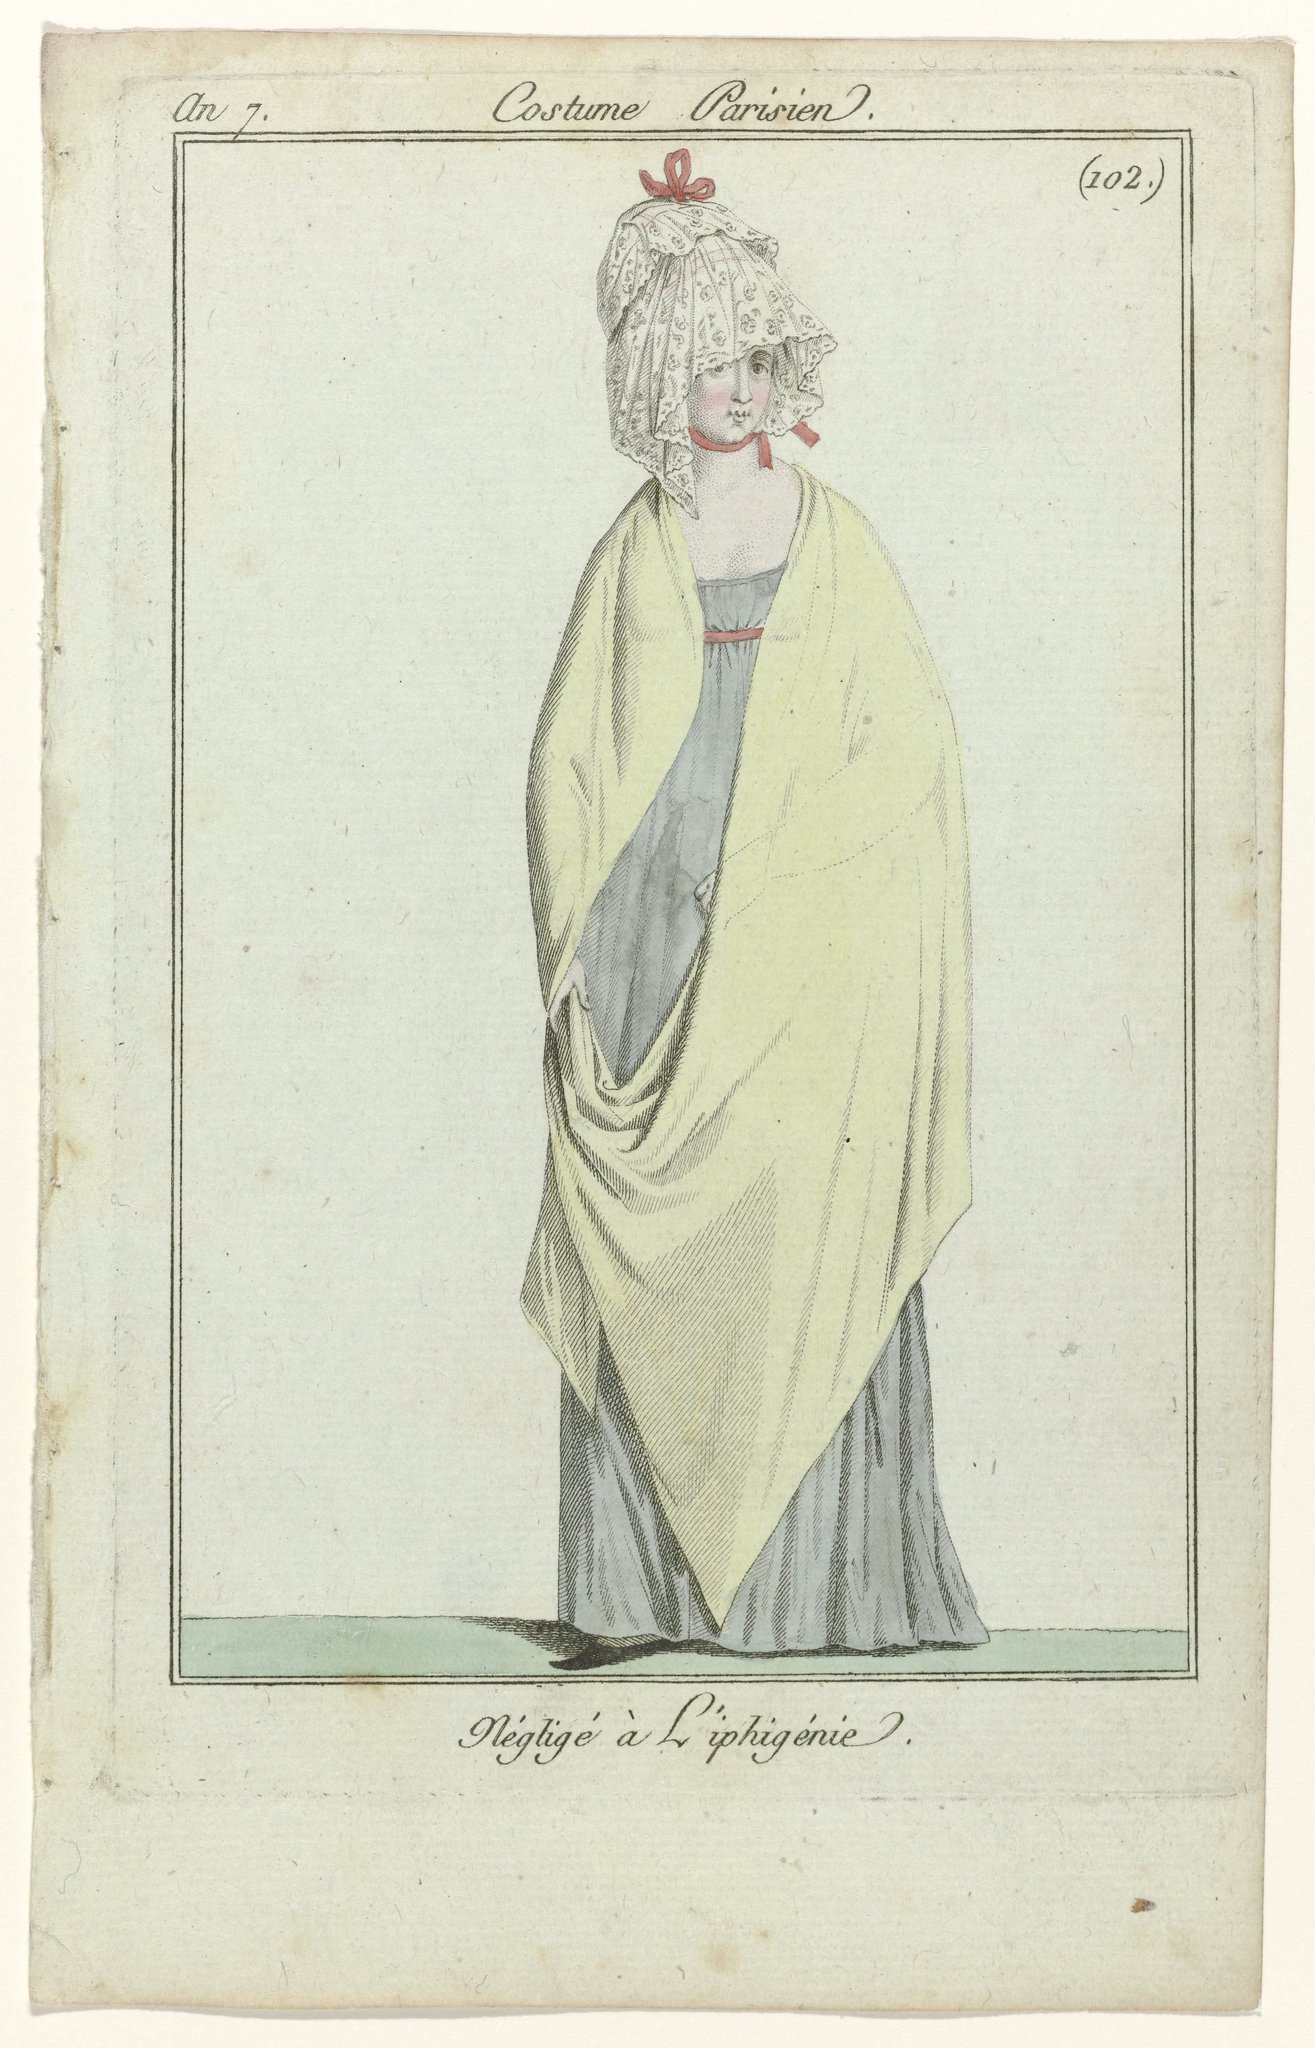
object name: fashion print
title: Journal des Dames et des Modes, Costume Parisien, 19 avril 1799, An 7 (102 bis) : Négligé à Líphigénie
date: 1799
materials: paper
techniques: engraving, hand coloring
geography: paris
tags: clothing for the upper part of the body (shawl) (+ women's clothes), head-gear: cap (+ women's clothes), fashion plates, shoes, sandals (+ women's clothes), dress, gown (+ women's clothes)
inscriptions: caption: ‘Négligé à Líphigénie’, title: ‘Costume Parisien.’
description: 'Négligé à L'iphigénie'. Japon met hoge taille, om de schouders een lange sjaal. Accessoires: geplooide muts met bloemmotief, platte schoen met puntige neus. De prent maakt deel uit van het modetijdschrift Journal des Dames et des Modes, uitgegeven door Sellèque, Parijs, 1797-1839.